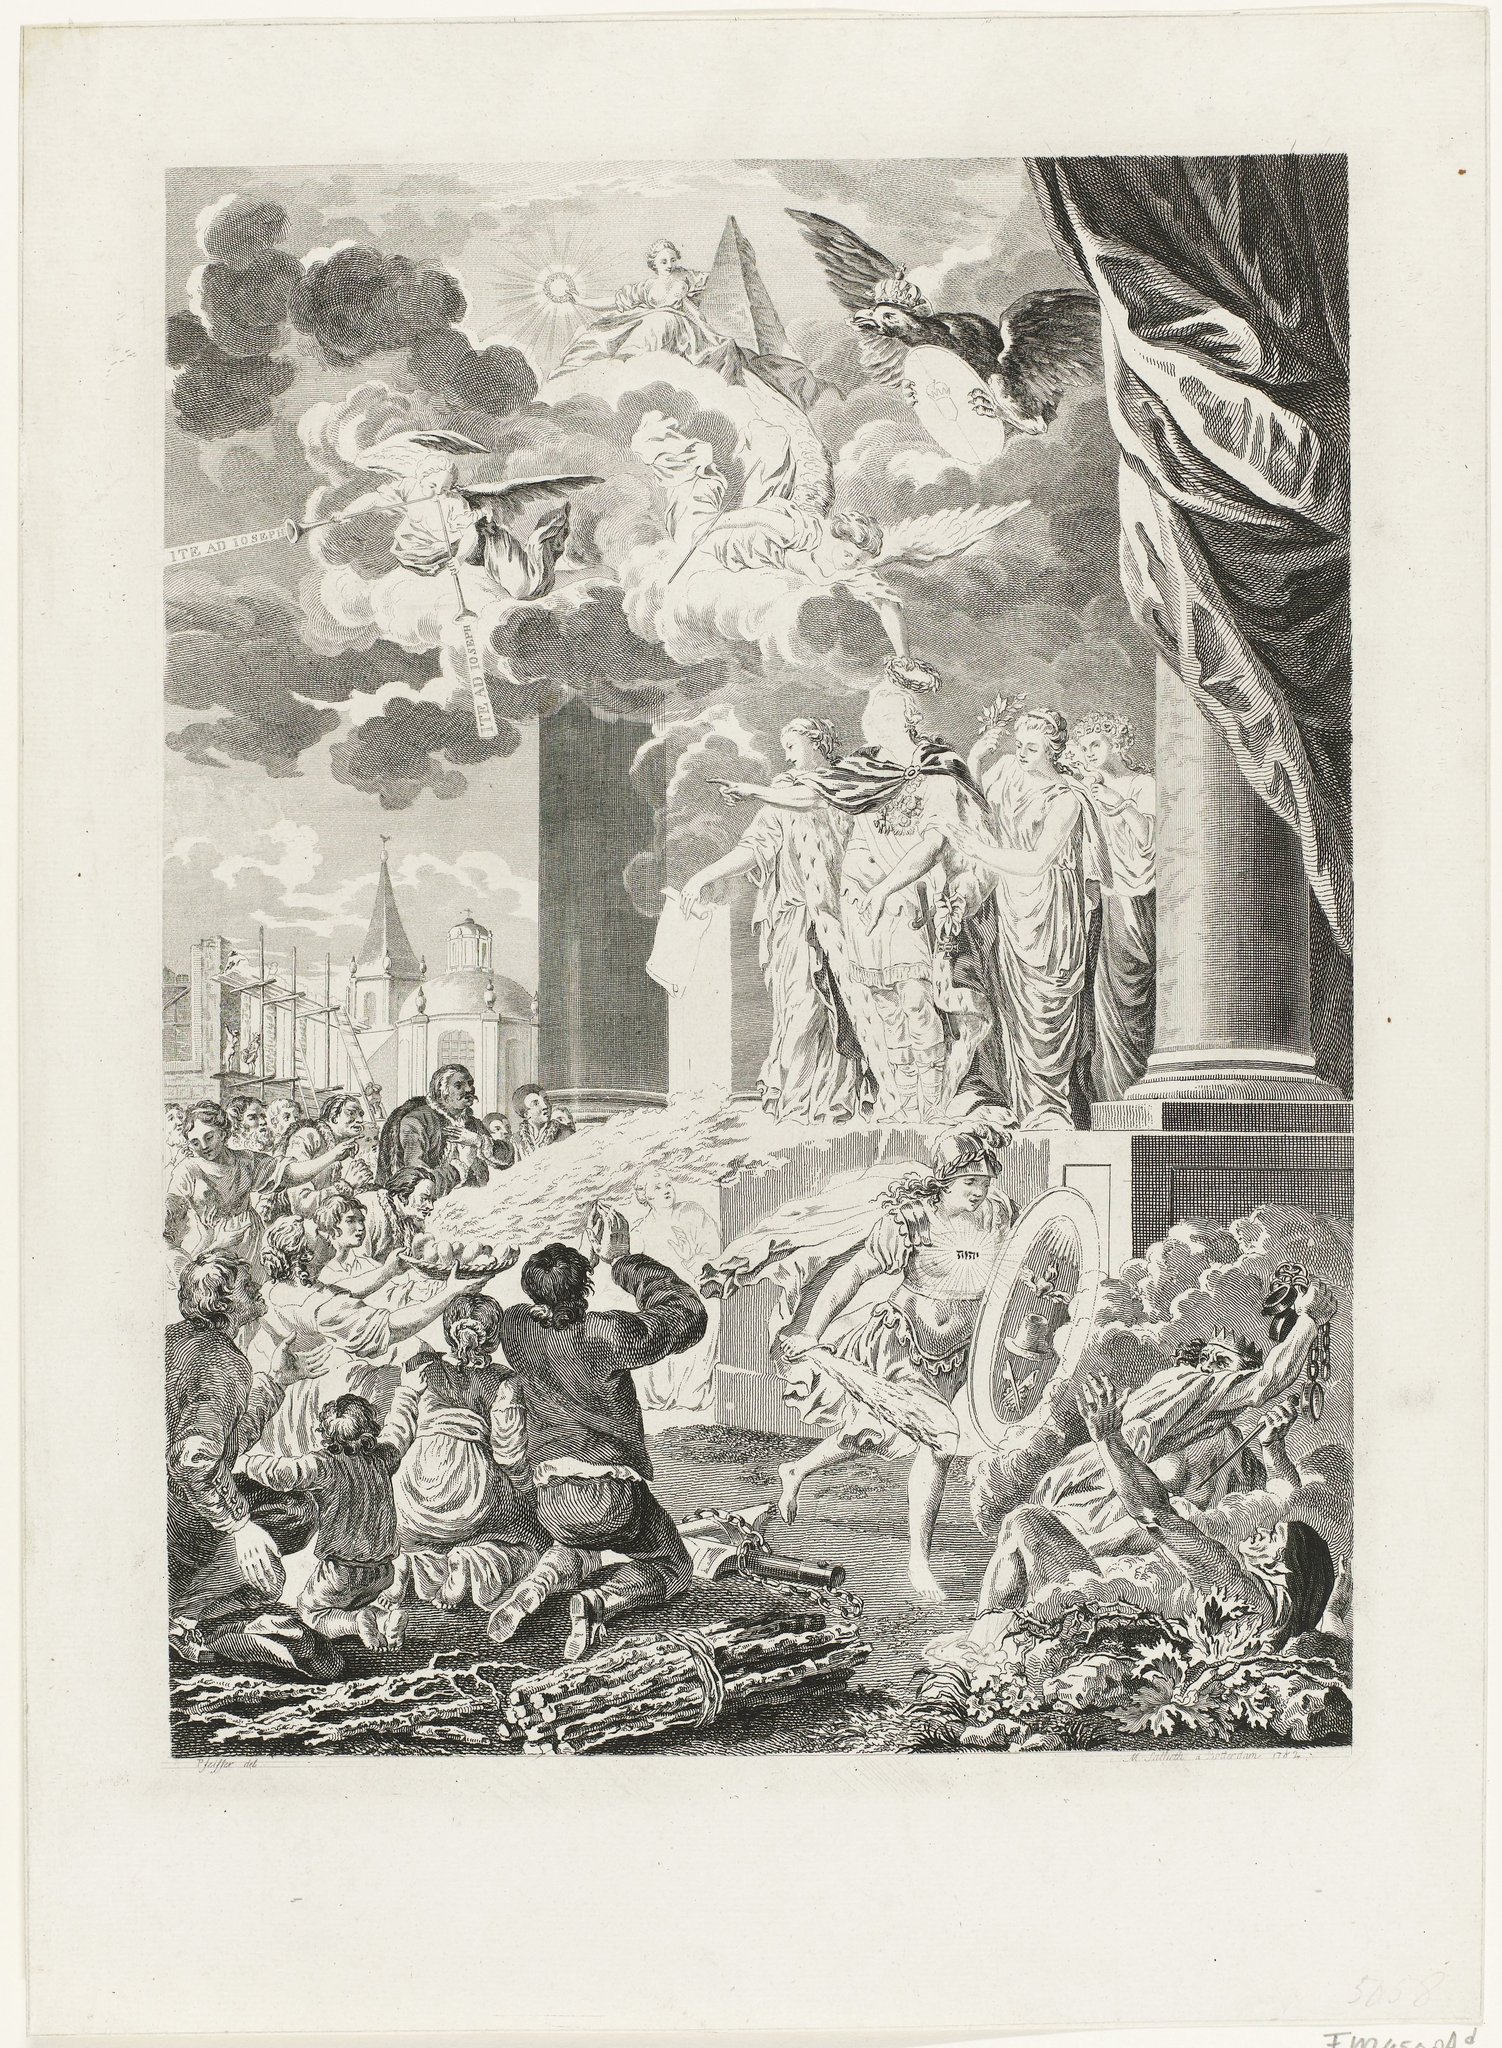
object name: print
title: Clementie van keizer Jozef II aan de protestanten, 1783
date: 1782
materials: paper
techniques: etching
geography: rotterdam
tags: maria christina van oostenrijk (1742-1798), vienna, jozef ii (duits keizer), prudence, 'prudentia'; 'prudenza' (ripa) ~ one of the four cardinal virtues, tolerance, long-suffering; 'longanimità', 'toleranza' (ripa) (+ abstract concept represented by female figure), indulgence, clemency; 'clemenza', 'clemenza & moderatione', 'indulgenza' (ripa) (+ abstract concept represented by female figure), the christian knight, 'miles christianus', building of church, allegories and personifications ~ protestantism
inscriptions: collector's mark: Lugt 2228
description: Allegorie op het edict van Joseph II over de godsdienstvrijheid voor protestanten, maart 1783. De keizer staat op het bordes van een tempel en wordt gekroond door de geest der Wijsheid. Naast de keizer de personificaties van Verdraagzaamheid, Goedertierenheid en Voorzichtigheid. Voor de keizer knielen (Hongaarse) protestantse onderdanen die hem in dankbaarheid hun harten aanbieden. Rechts worden de Dwingelandij en de Onwetendheid verjaagd door de Vrijheid van Godsdienst in harnas met vlammend zwaard en schild waarop 'Aurea libertas'. Op de achtergrond een protestantse kerk in aanbouw.